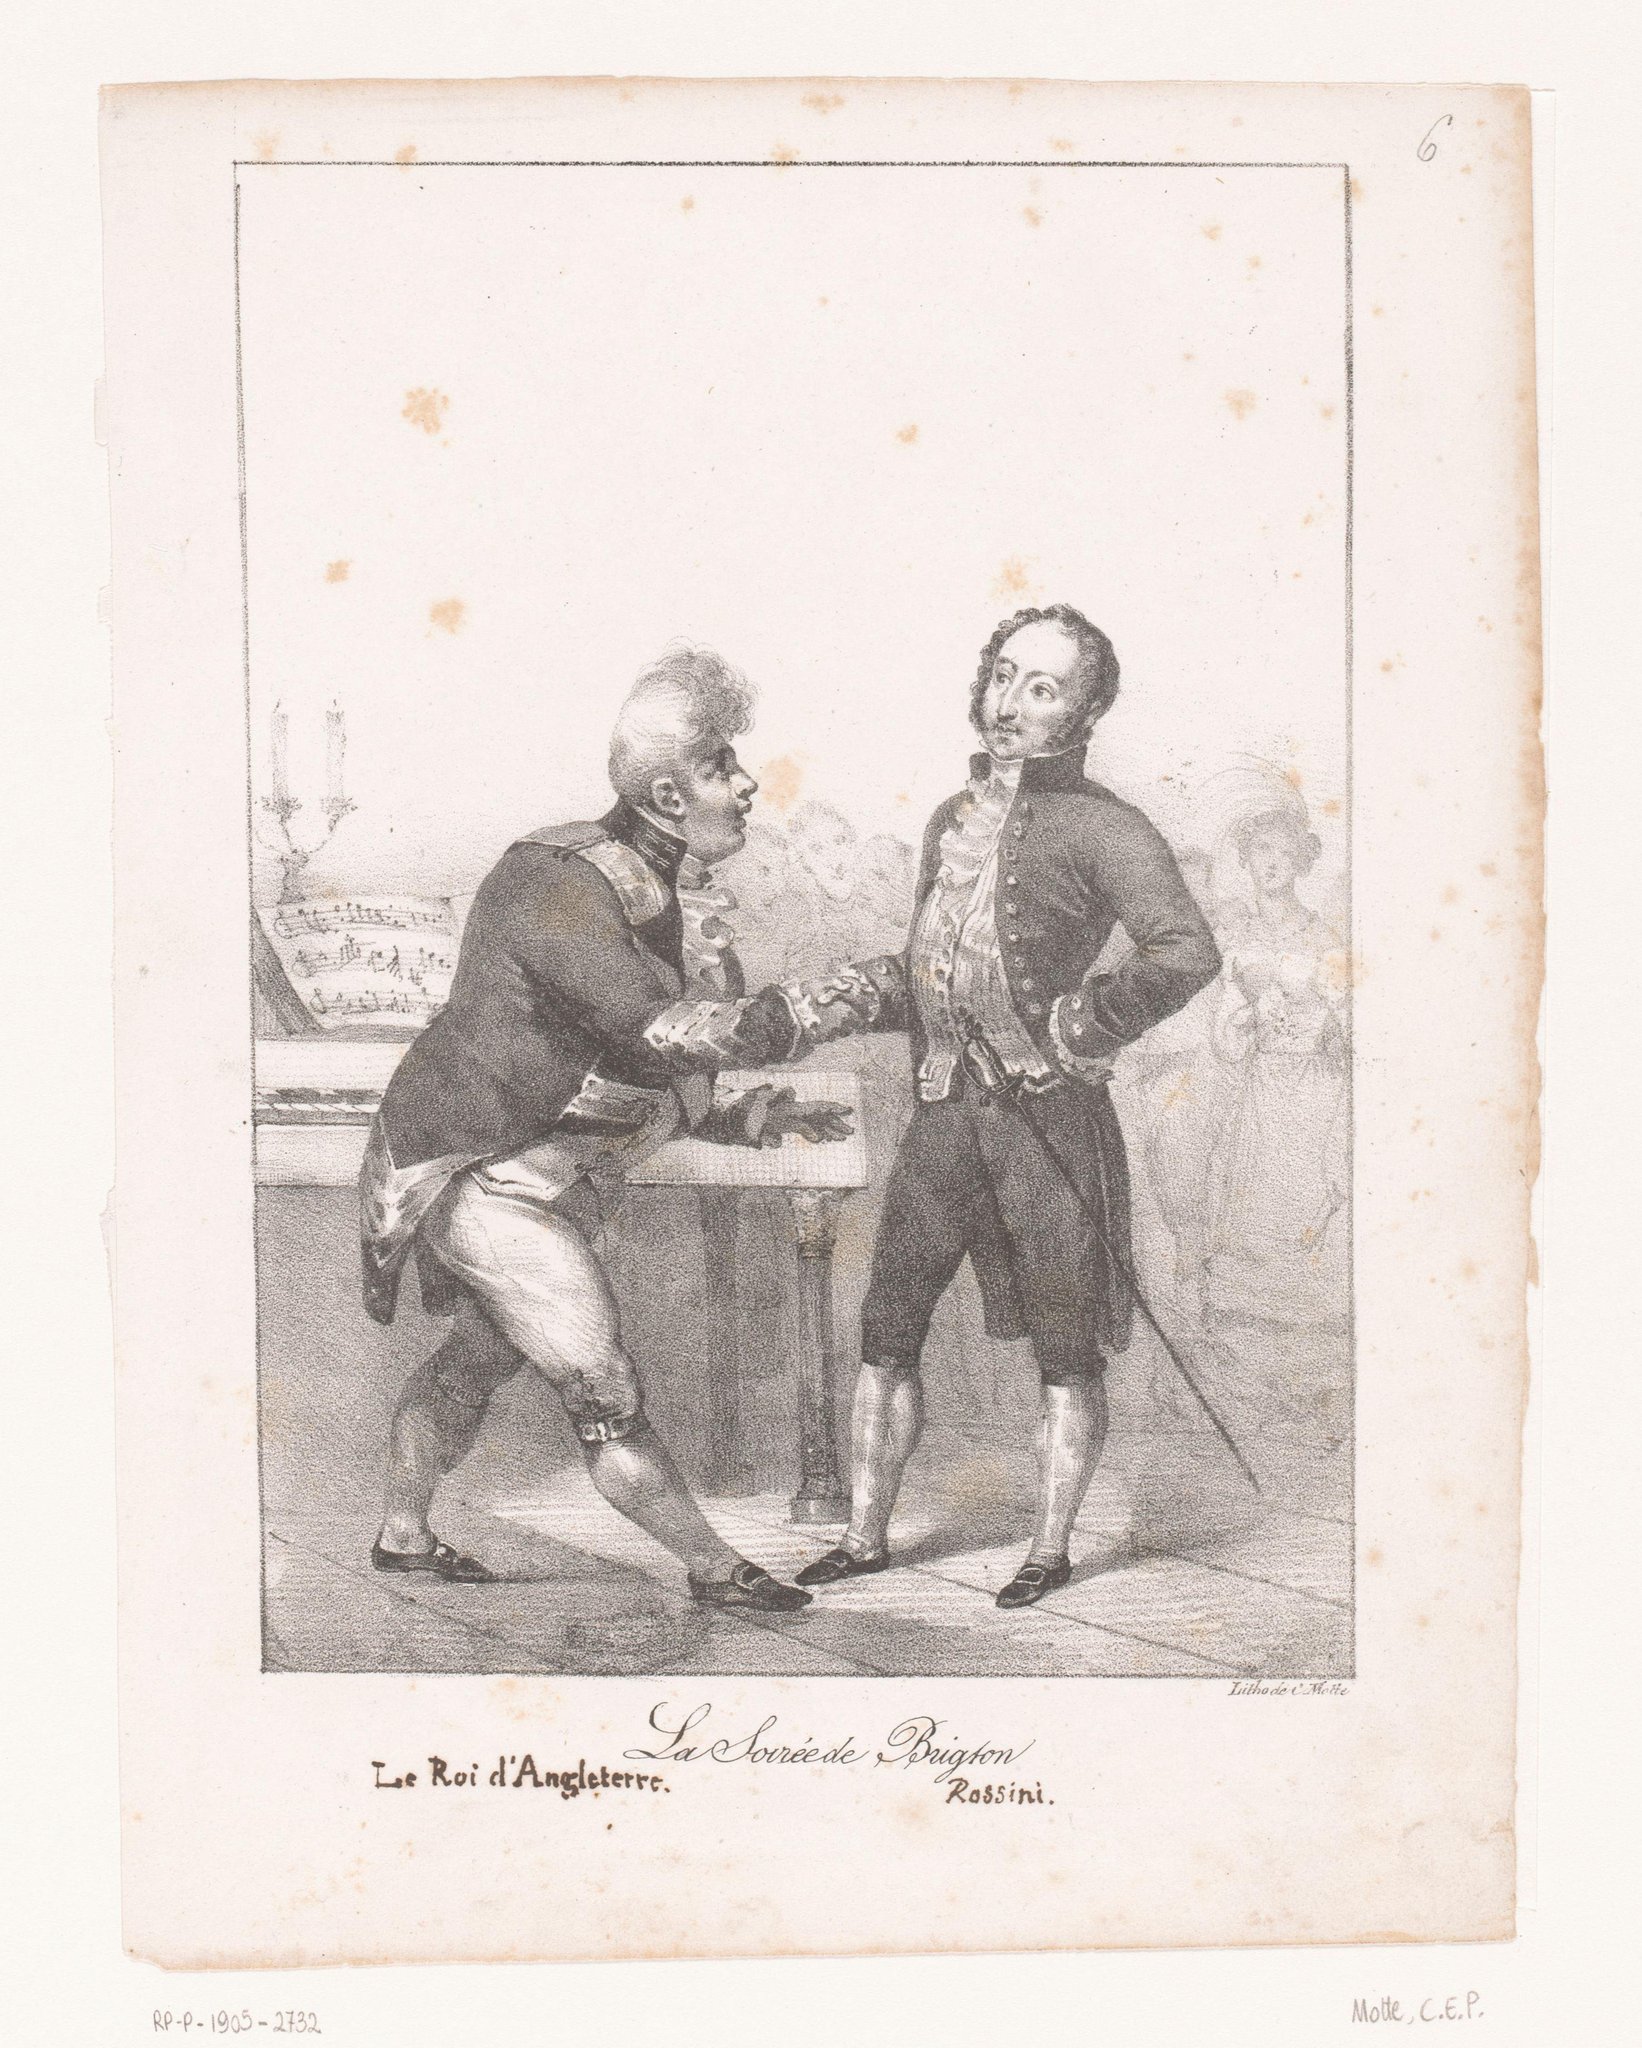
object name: print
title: Koning George IV en Gioacchino Antonio Rossini schudden elkaar de hand in Brighton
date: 1817-1837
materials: paper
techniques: lithograph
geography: paris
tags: gioacchino antonio rossini, george iv (koning van het verenigd koninkrijk), fashion, clothing, dancing, popular music, street music, king, composer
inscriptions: inscription: ‘Le Roi d'Angleterre. Rossini.’, collector's mark: Lugt 2228